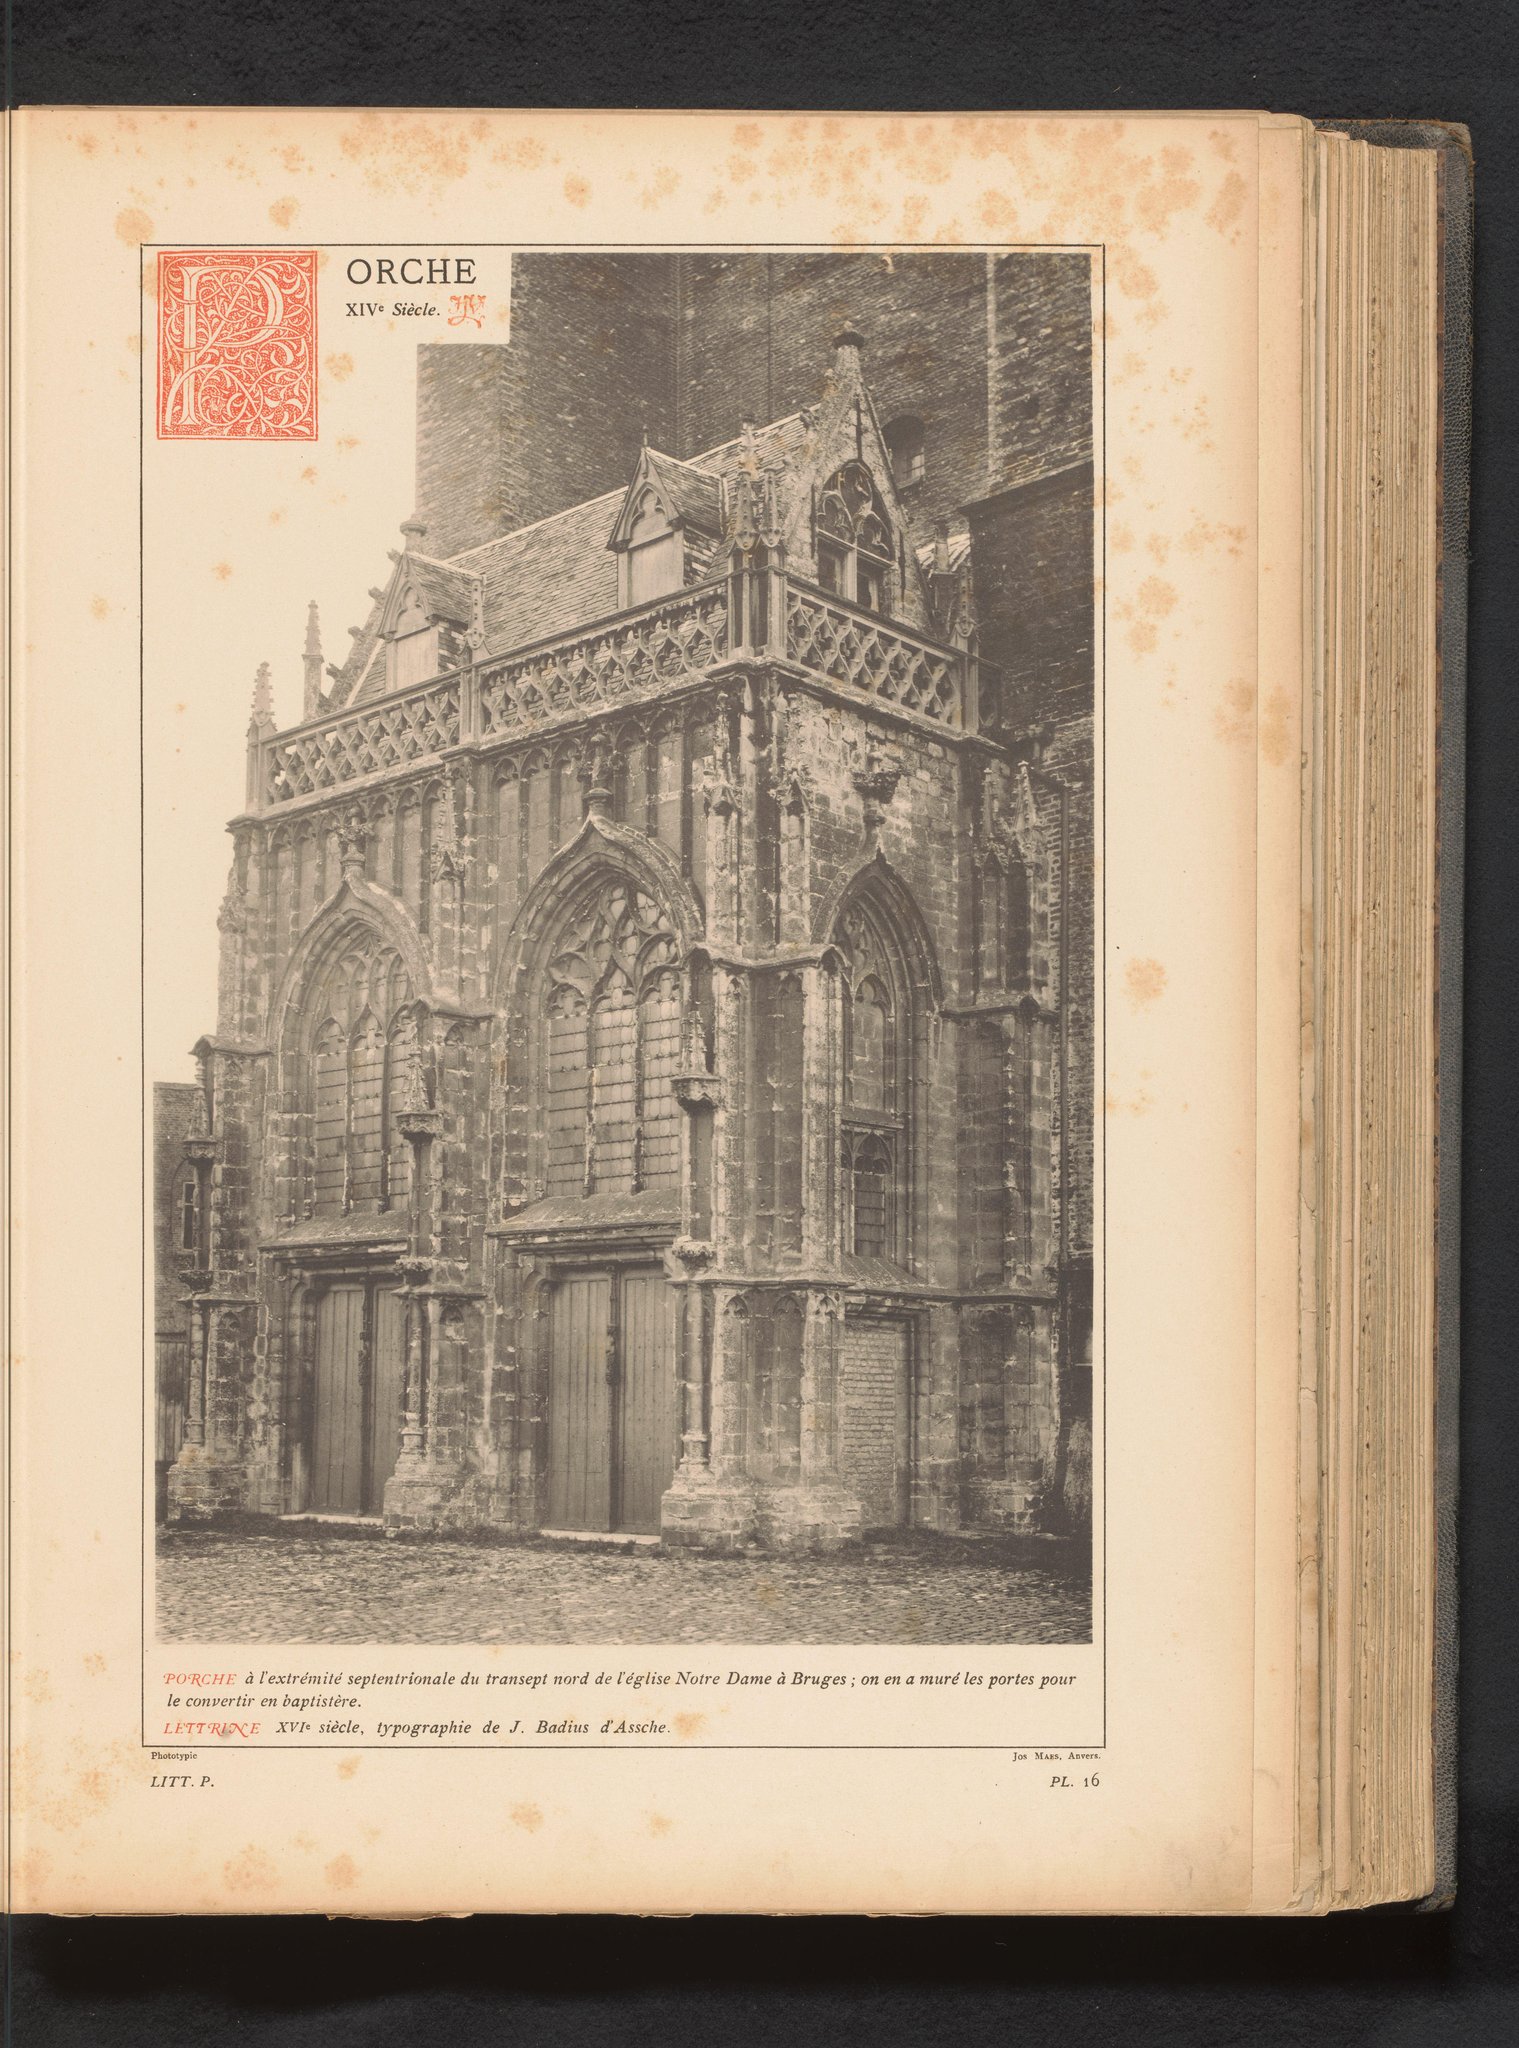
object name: photomechanical print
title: Gezicht op de Onze-Lieve-Vrouwekerk te Brugge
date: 1876-1881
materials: paper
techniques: photograph, photolithography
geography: bruges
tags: church (exterior)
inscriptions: inscription: ‘LITT. P. - PL. 16.’, monogram: ‘JJvY’, inscription: ‘PORCHE à l'extrémité (...)’